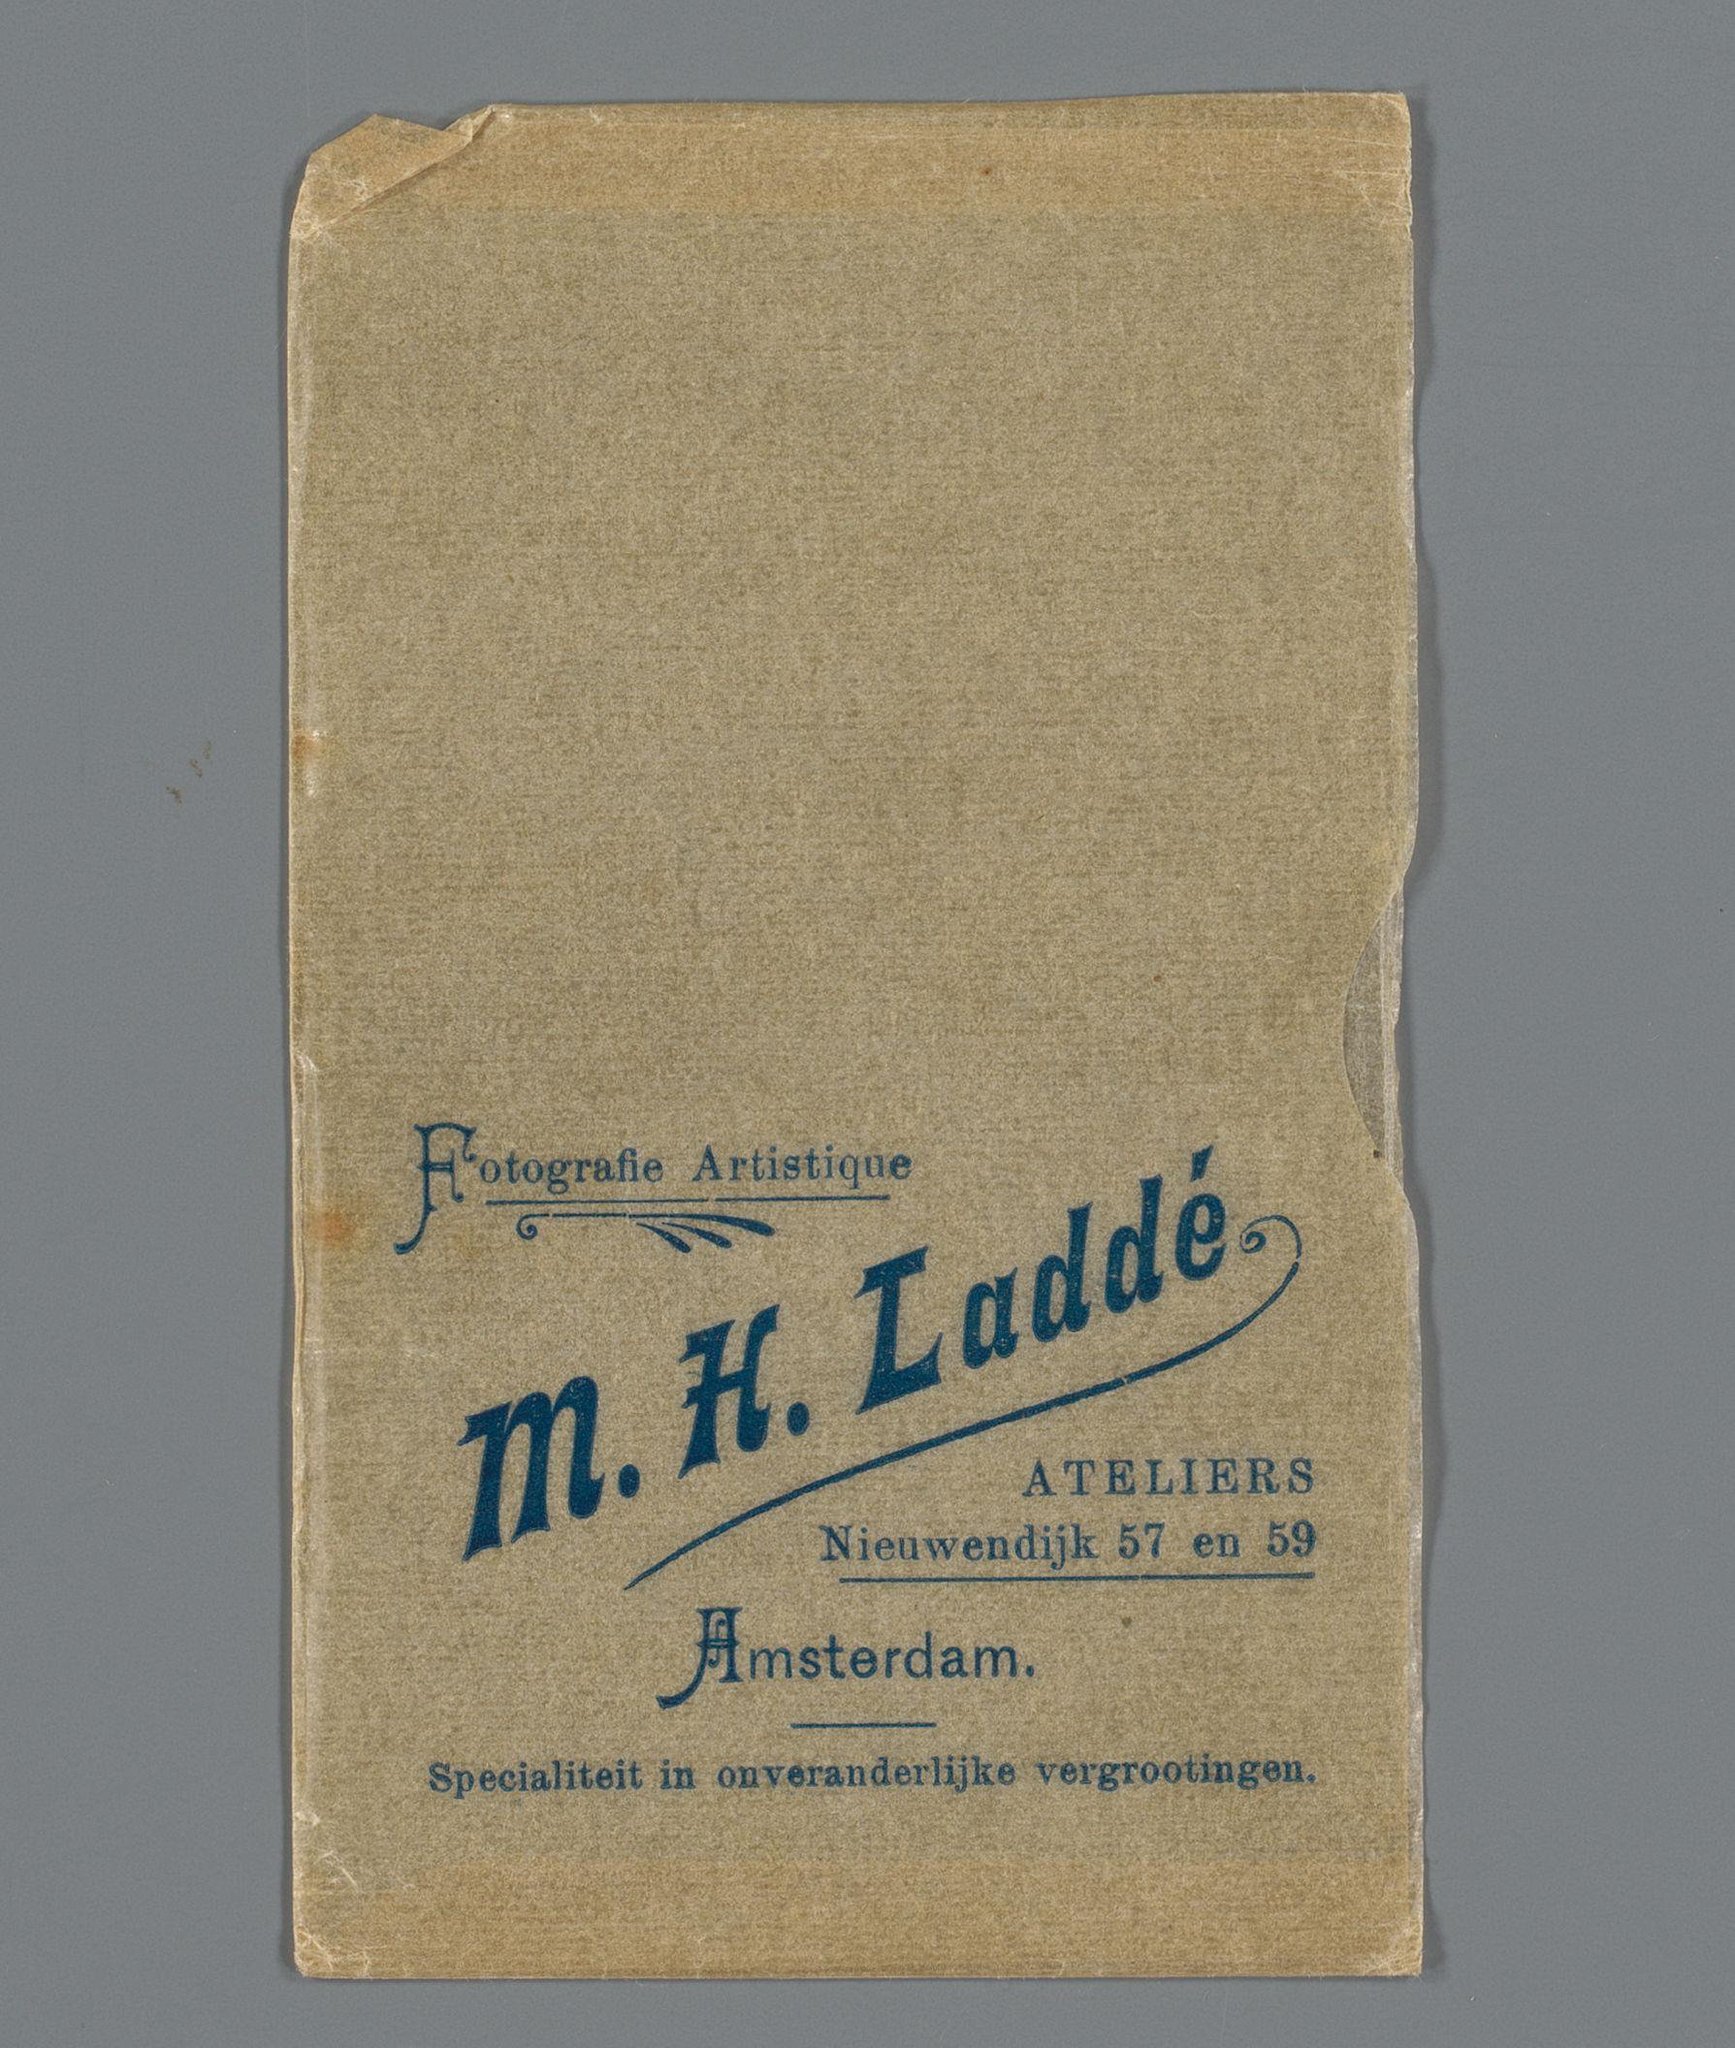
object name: covering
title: Hoes voor een carte-de-visite gemaakt door M.H. Laddé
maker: machiel hendricus laddé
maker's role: fotograaf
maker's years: 1866-1932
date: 1911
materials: paper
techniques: letterpress printing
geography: amsterdam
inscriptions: inscription: ‘Fotografie Artistique/ M.H. Laddé/ Ateliers/ Nieuwendijk 57 en 59/ Amsterdam./ Specialiteit in onveranderlijke vergrootingen.’